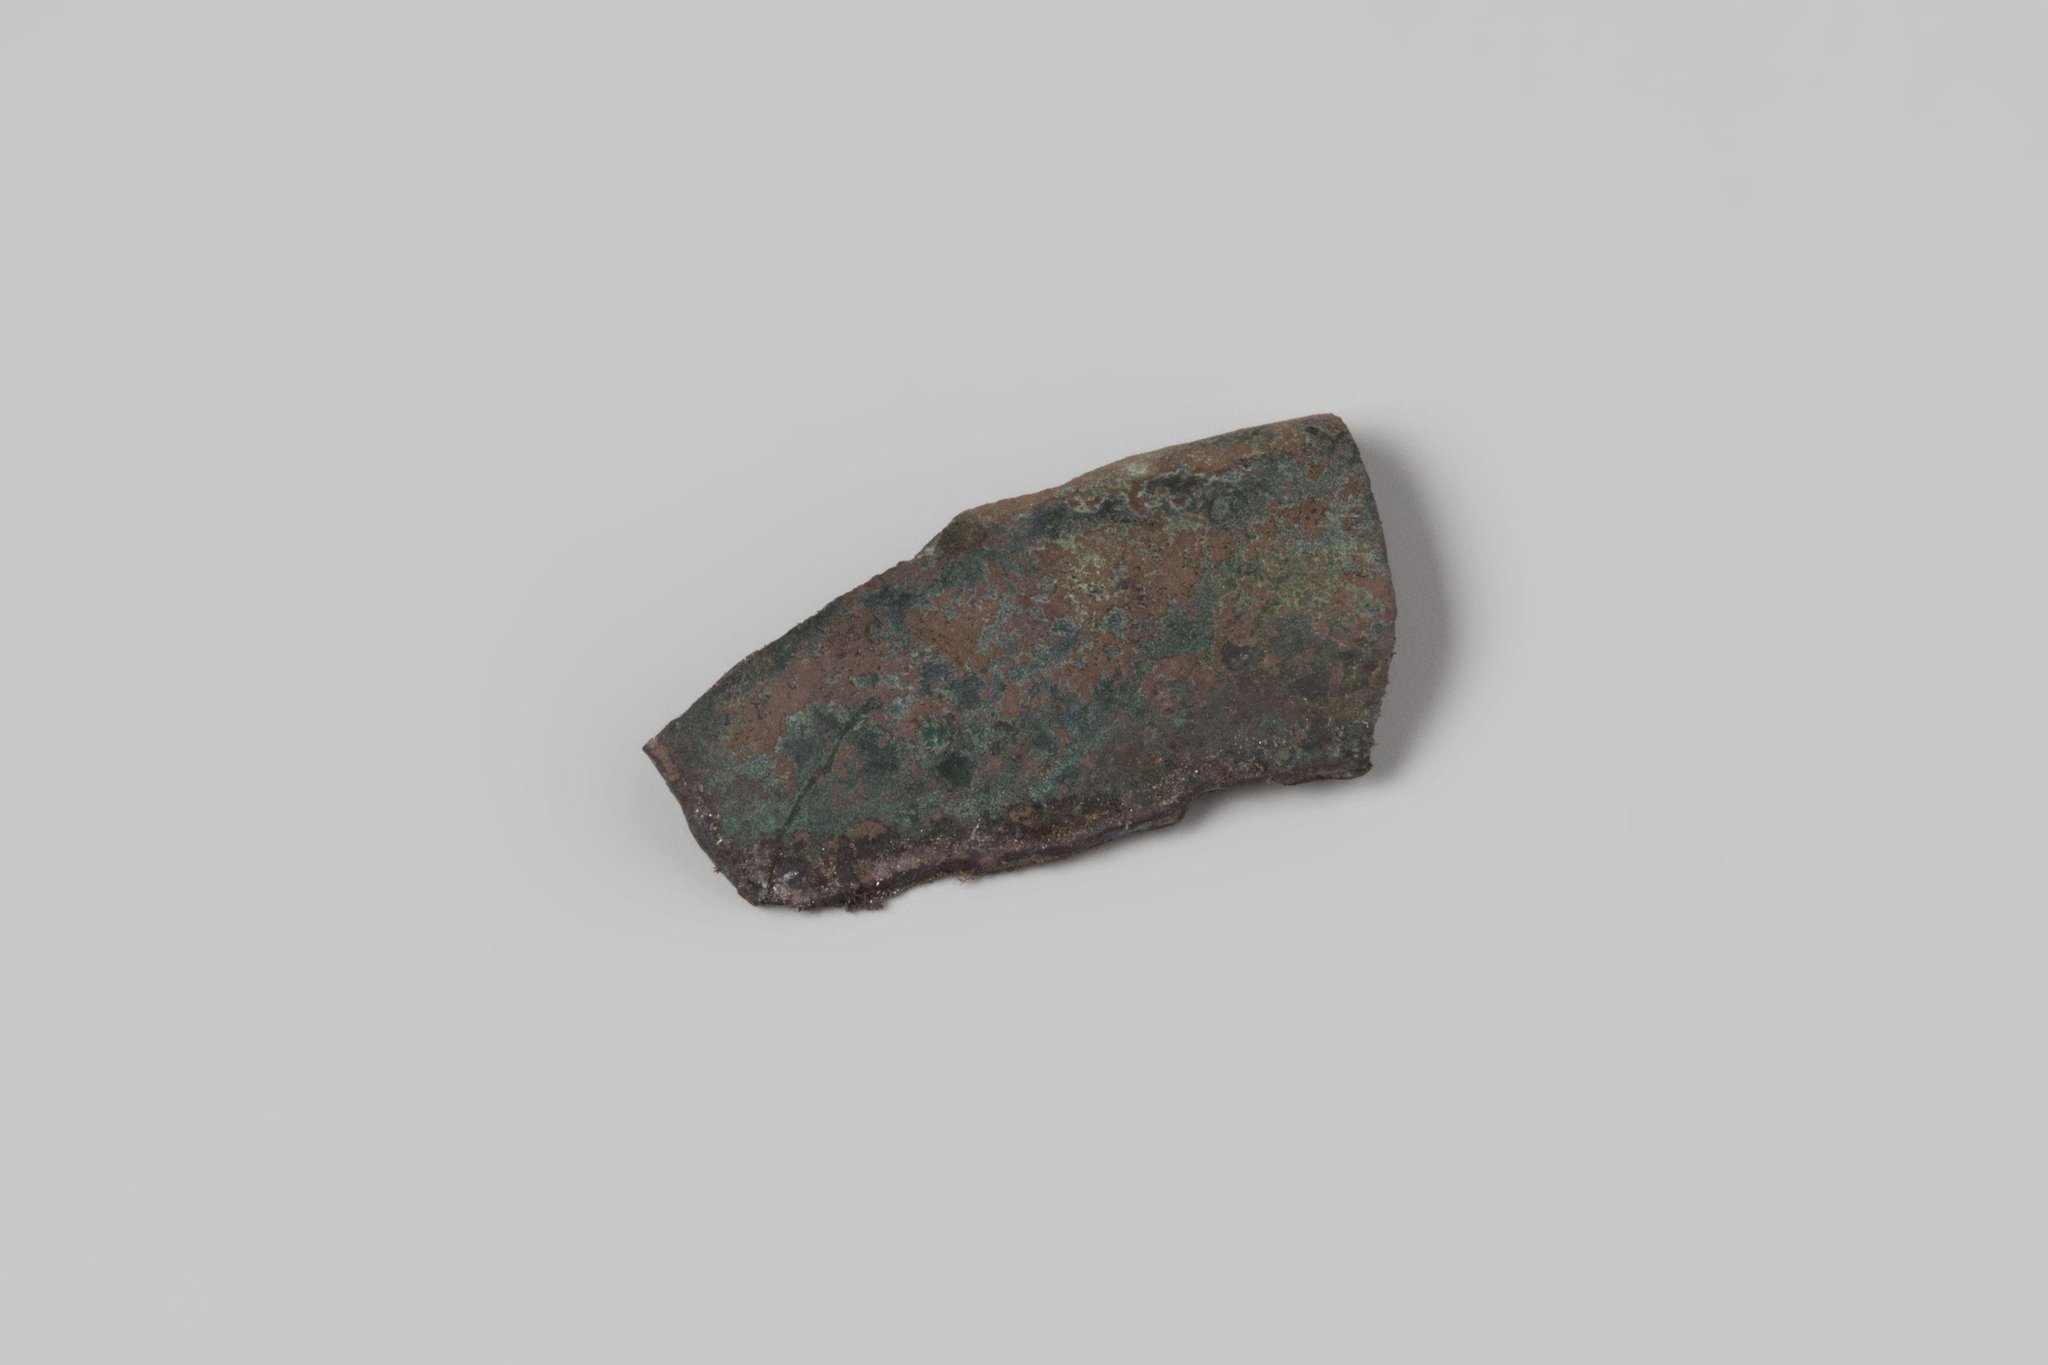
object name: scheepswrakvondst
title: Fragment van zilver uit het wrak van de Oost-Indiëvaarder Hollandia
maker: Anonymous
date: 1700-1743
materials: silver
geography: netherlands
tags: verenigde oostindische compagnie, hollandia (schip), annet